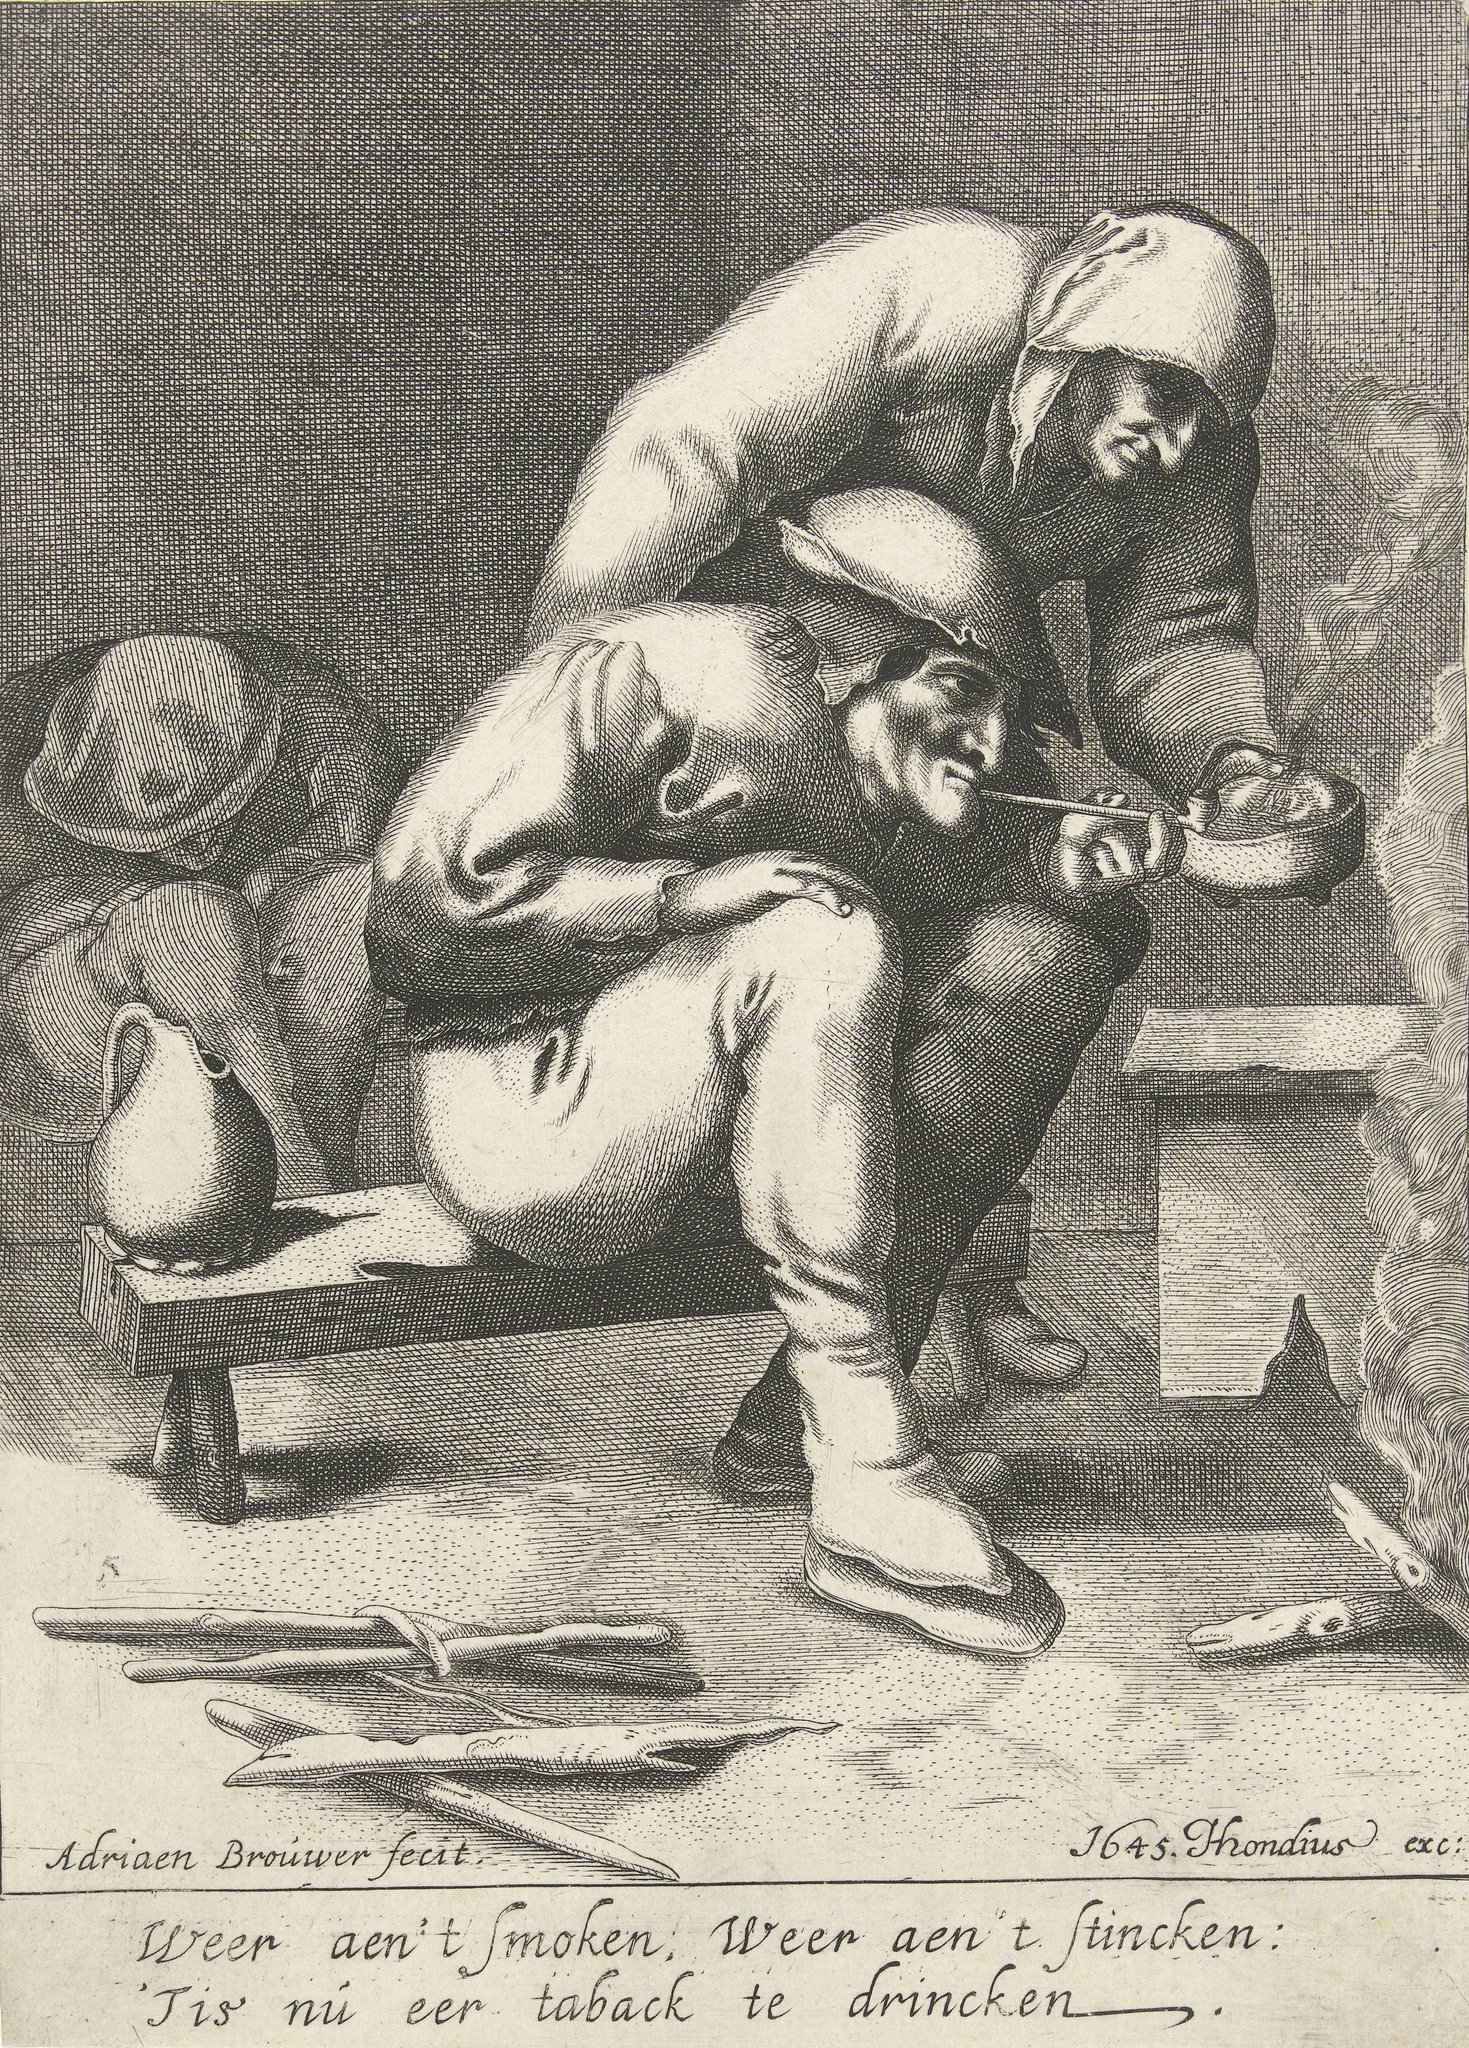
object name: print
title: Rokende man, met achter zich een vrouw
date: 1645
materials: paper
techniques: engraving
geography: amsterdam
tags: sitting figure, pipe ~ tobacco (+ taking (particular) foodstuffs: eating, drinking, smoking, chewing, etc.), open fire, fire-place, stove (in kitchen), bench (+ wood and other phytogenic material)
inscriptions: collector's mark: Lugt 240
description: Een rokende man op een bankje, met achter zich een vrouw, bij een open vuur. Op de achtergrond nog een zittende figuur. Onder de voorstelling twee regels in het Nederlands.